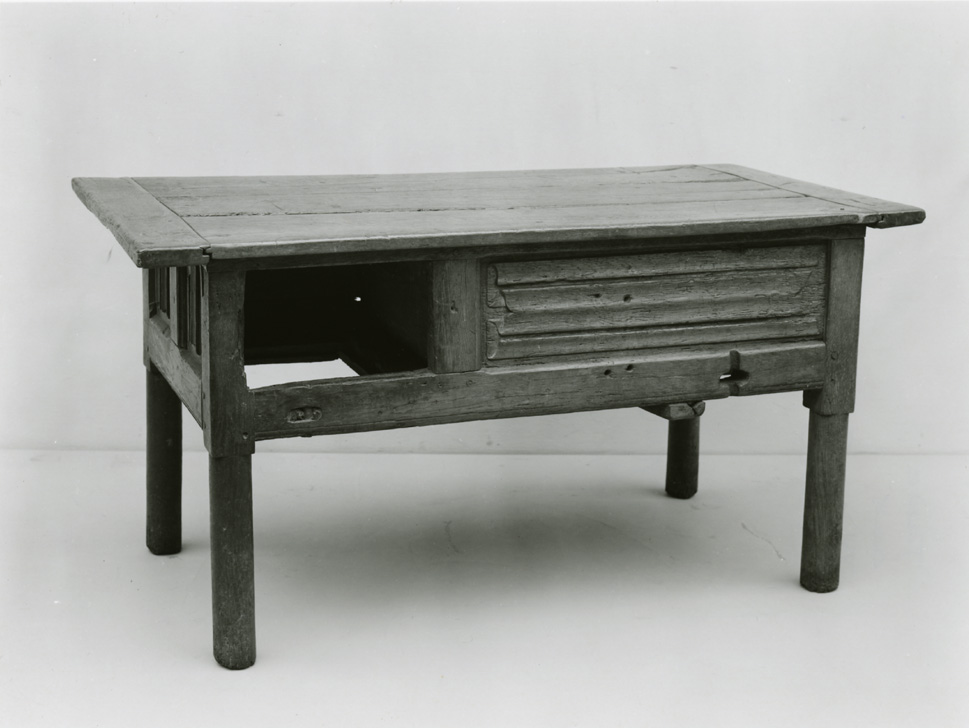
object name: table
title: Small Table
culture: french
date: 1401-1500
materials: wood